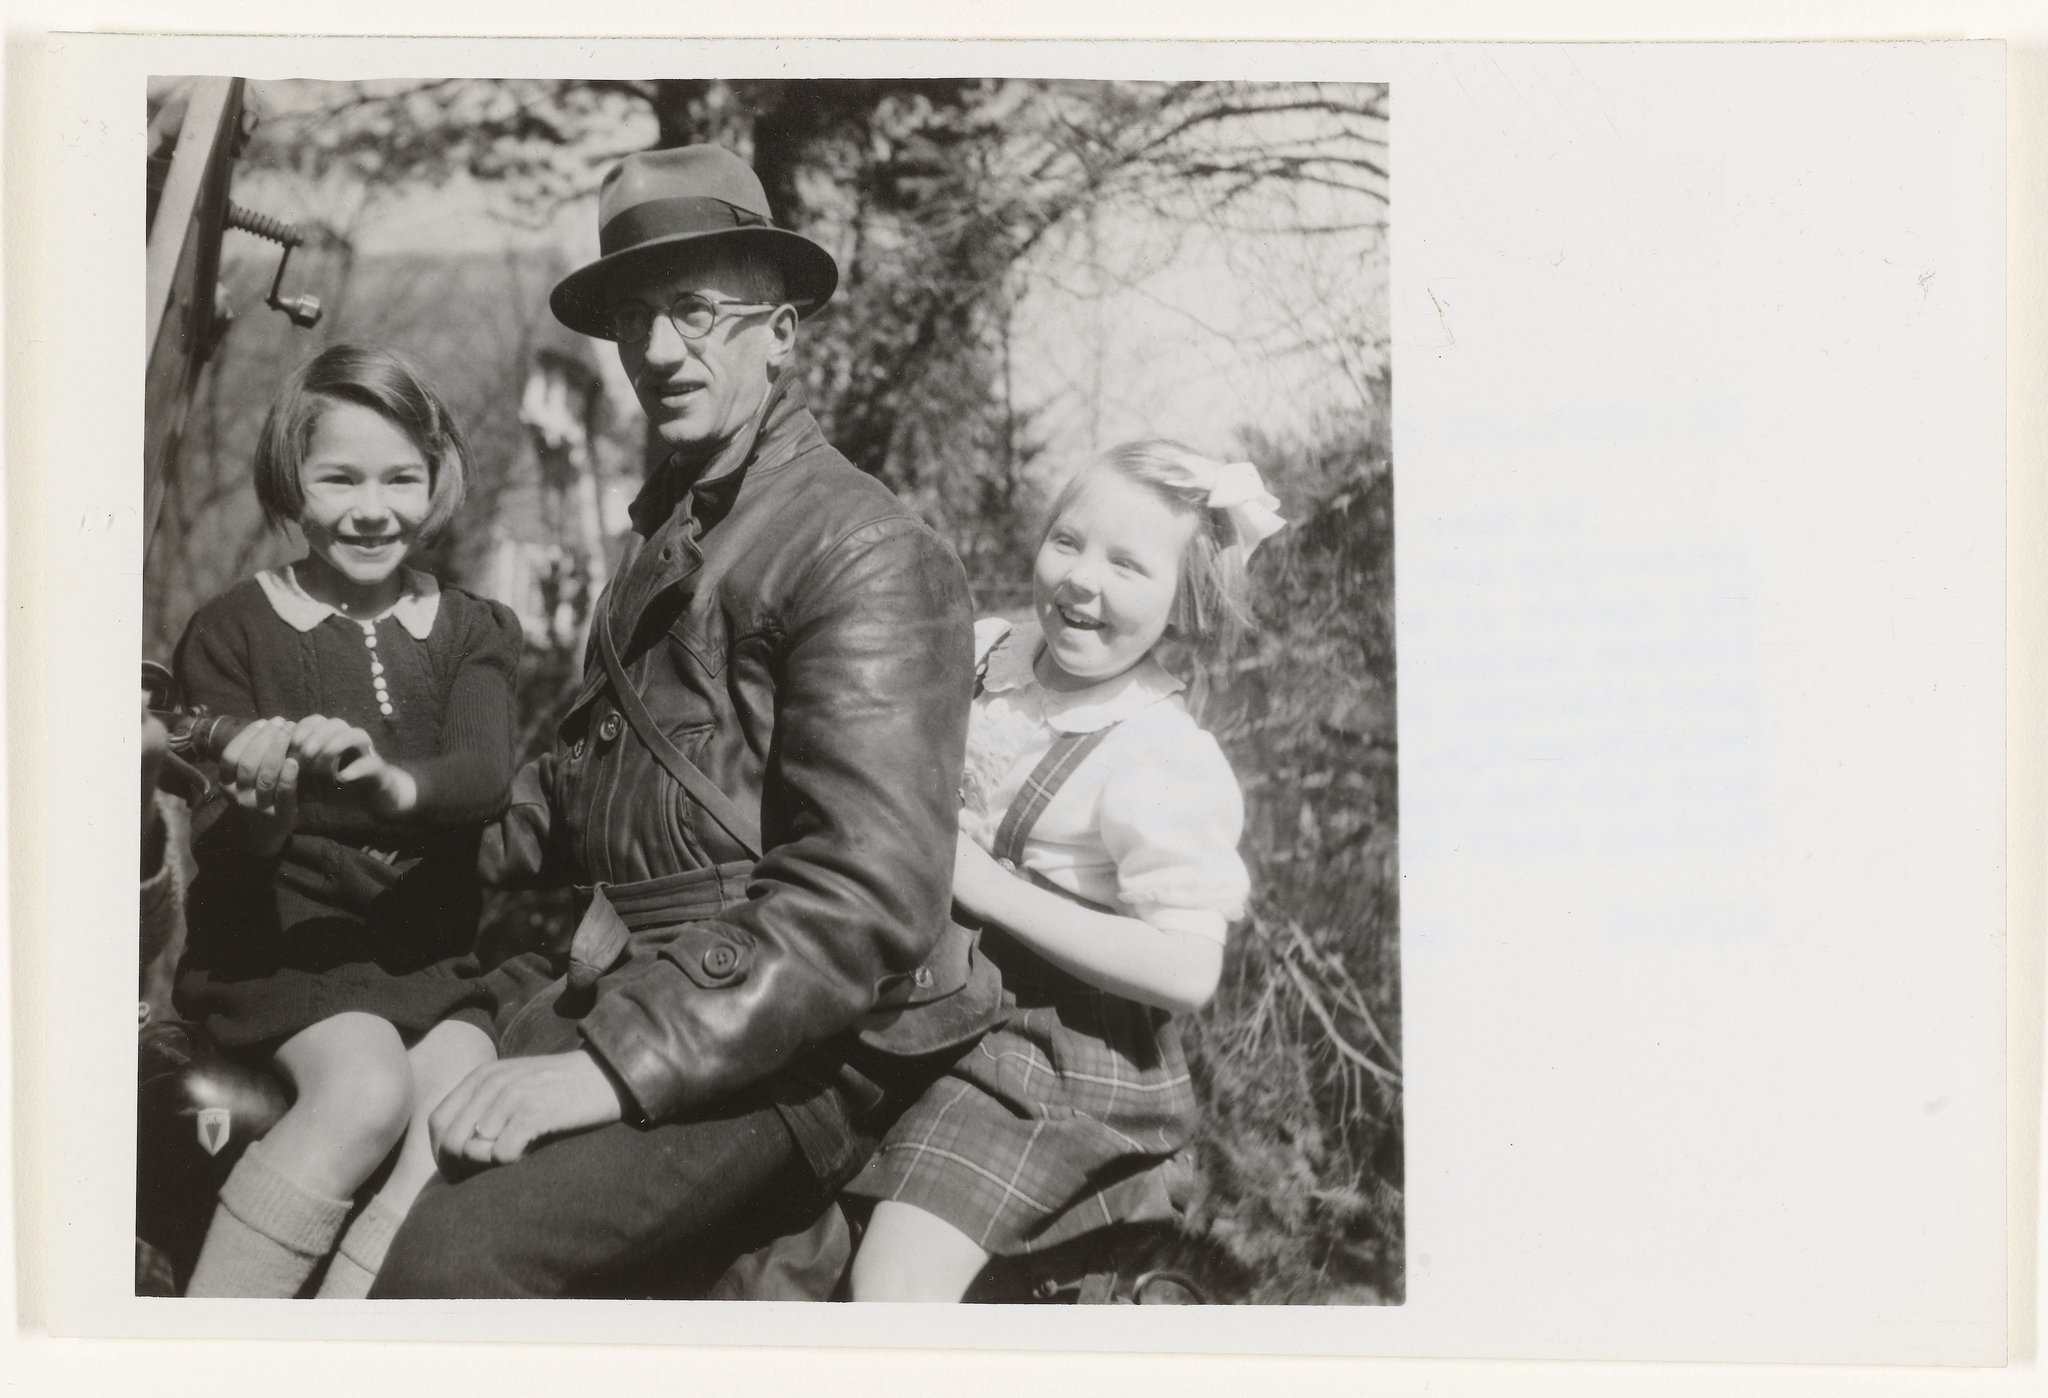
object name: photograph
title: Beatrix als leerling van de werkplaats Kindergemeenschap Bilthoven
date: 1946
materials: photographic support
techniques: photography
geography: bilthoven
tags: beatrix (koningin der nederlanden), amsterdam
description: Leerlingen van de Werkplaats Kindergemeenschap Bilthoven, ook genoemd de Werkplaats Kees Boeke. Zowel Prinses beatrix als Prinses Irene zaten op deze school. Hier Beatrix bij de bakker op zijn kar.